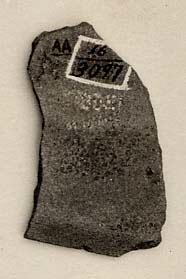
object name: gritstone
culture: canadian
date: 1902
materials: stone